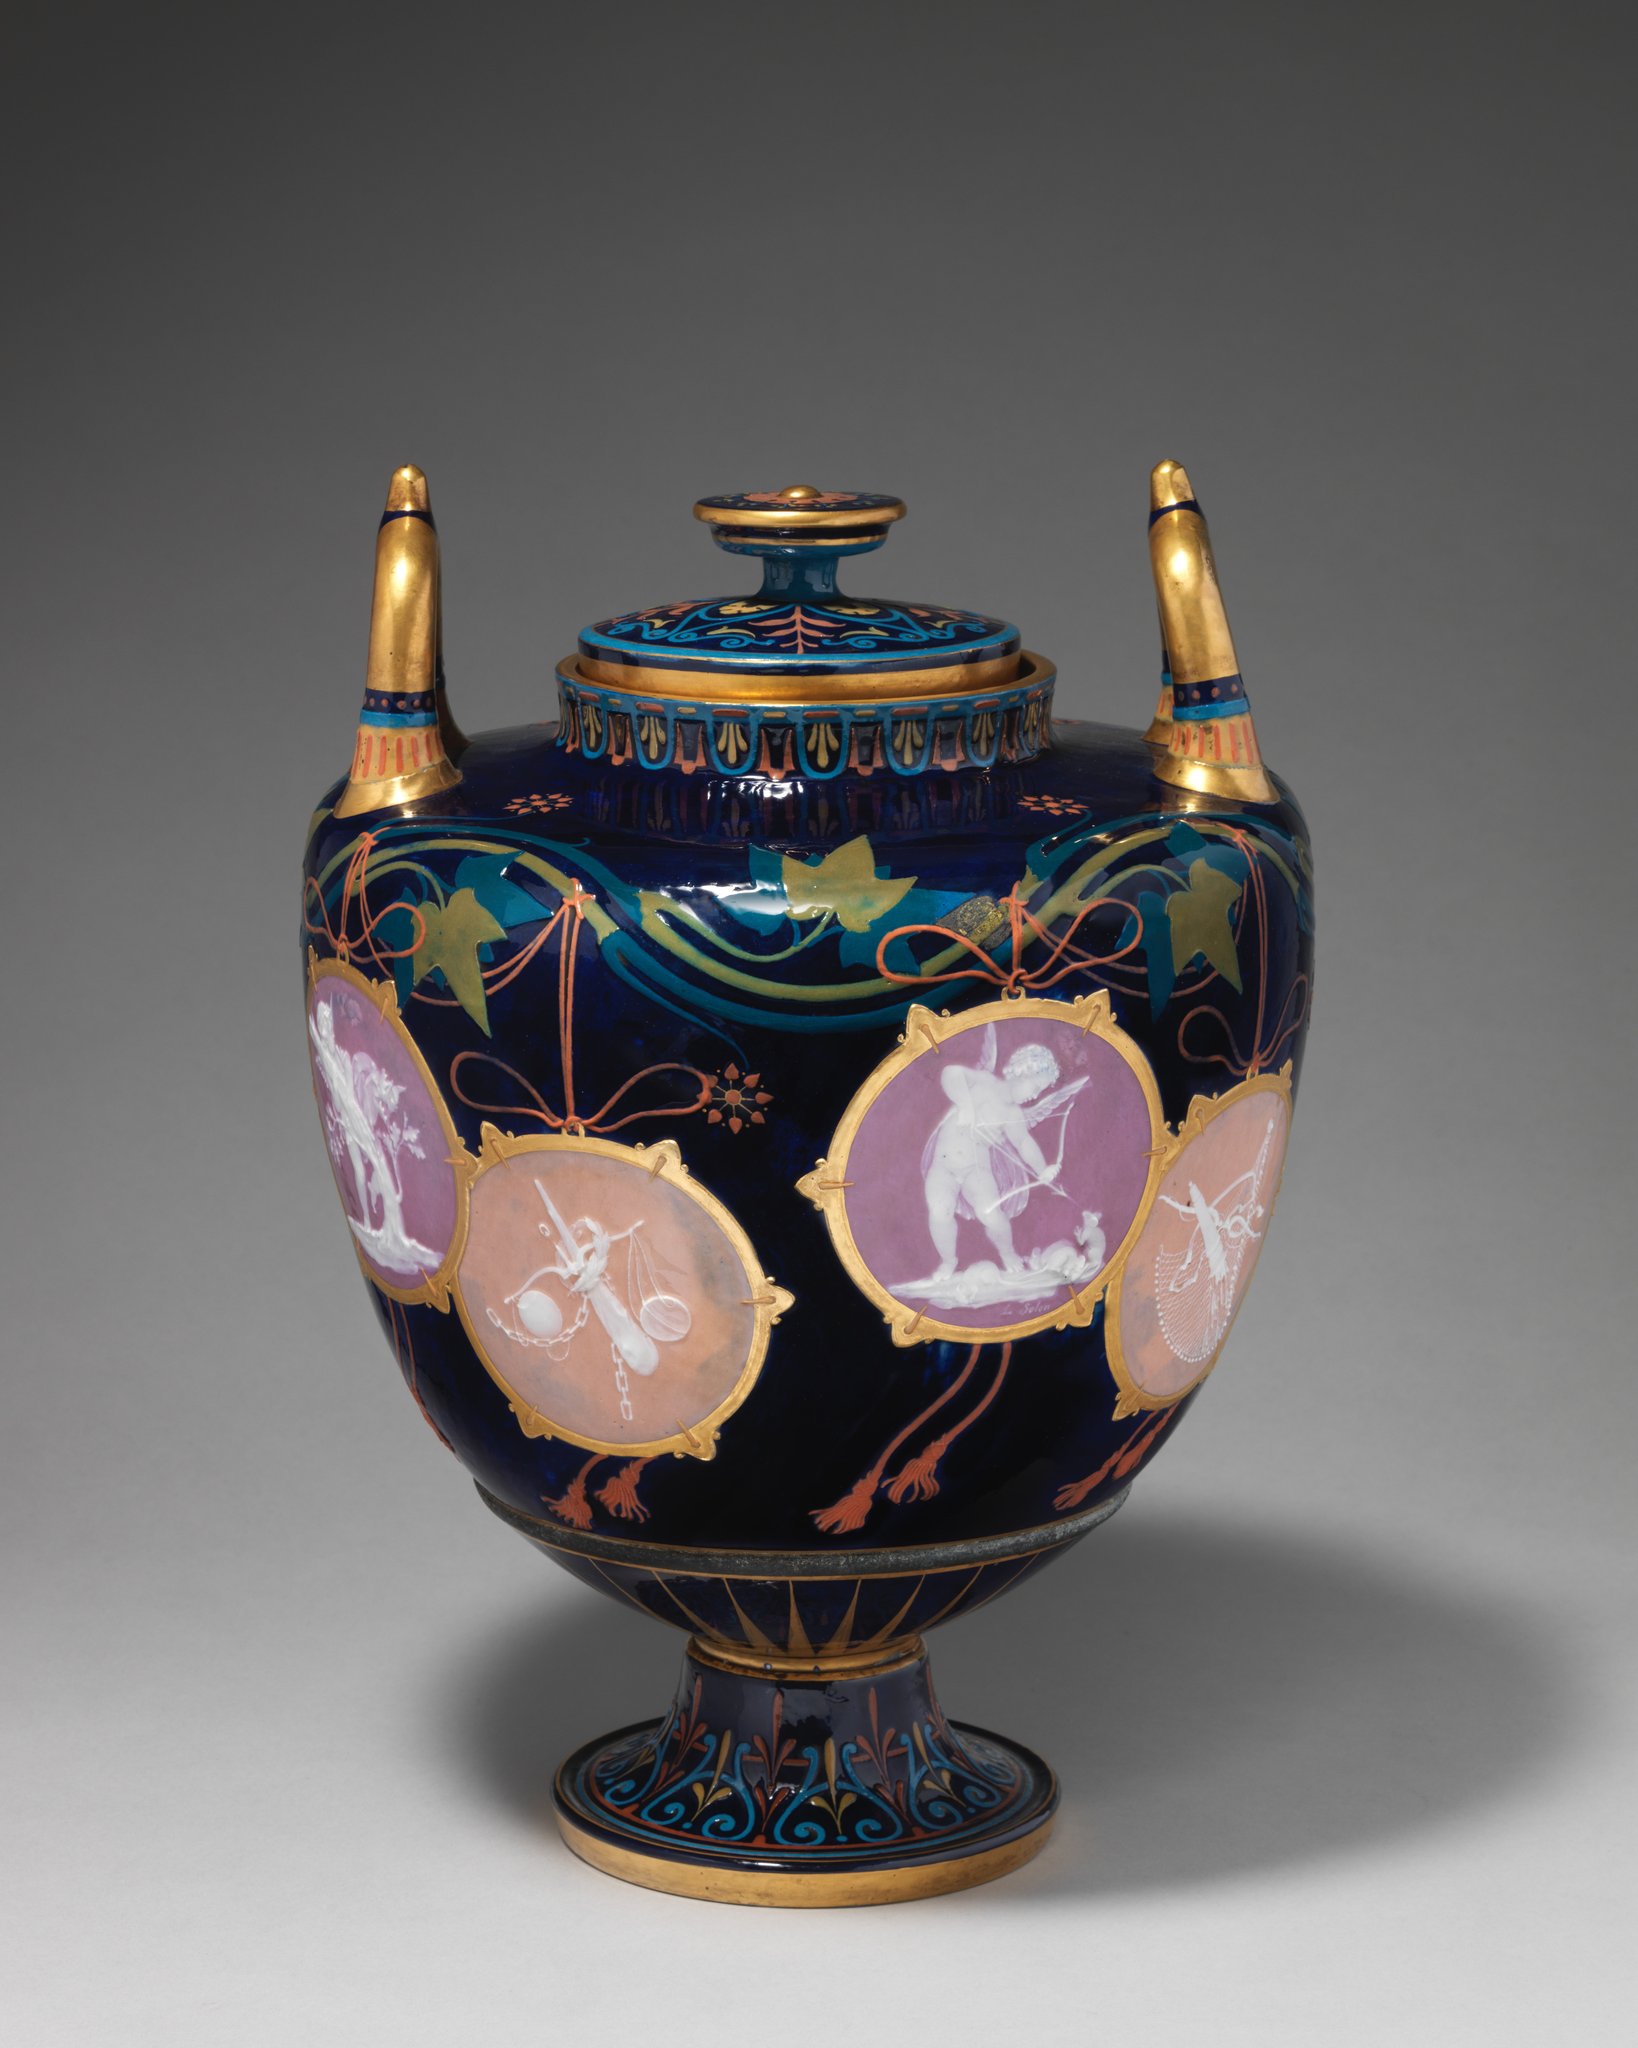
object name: vase pair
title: "Pompeian" vase with cover (one of a pair)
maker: minton(s)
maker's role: maker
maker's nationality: british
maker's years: 1793-2001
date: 1874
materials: enamel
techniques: gilding